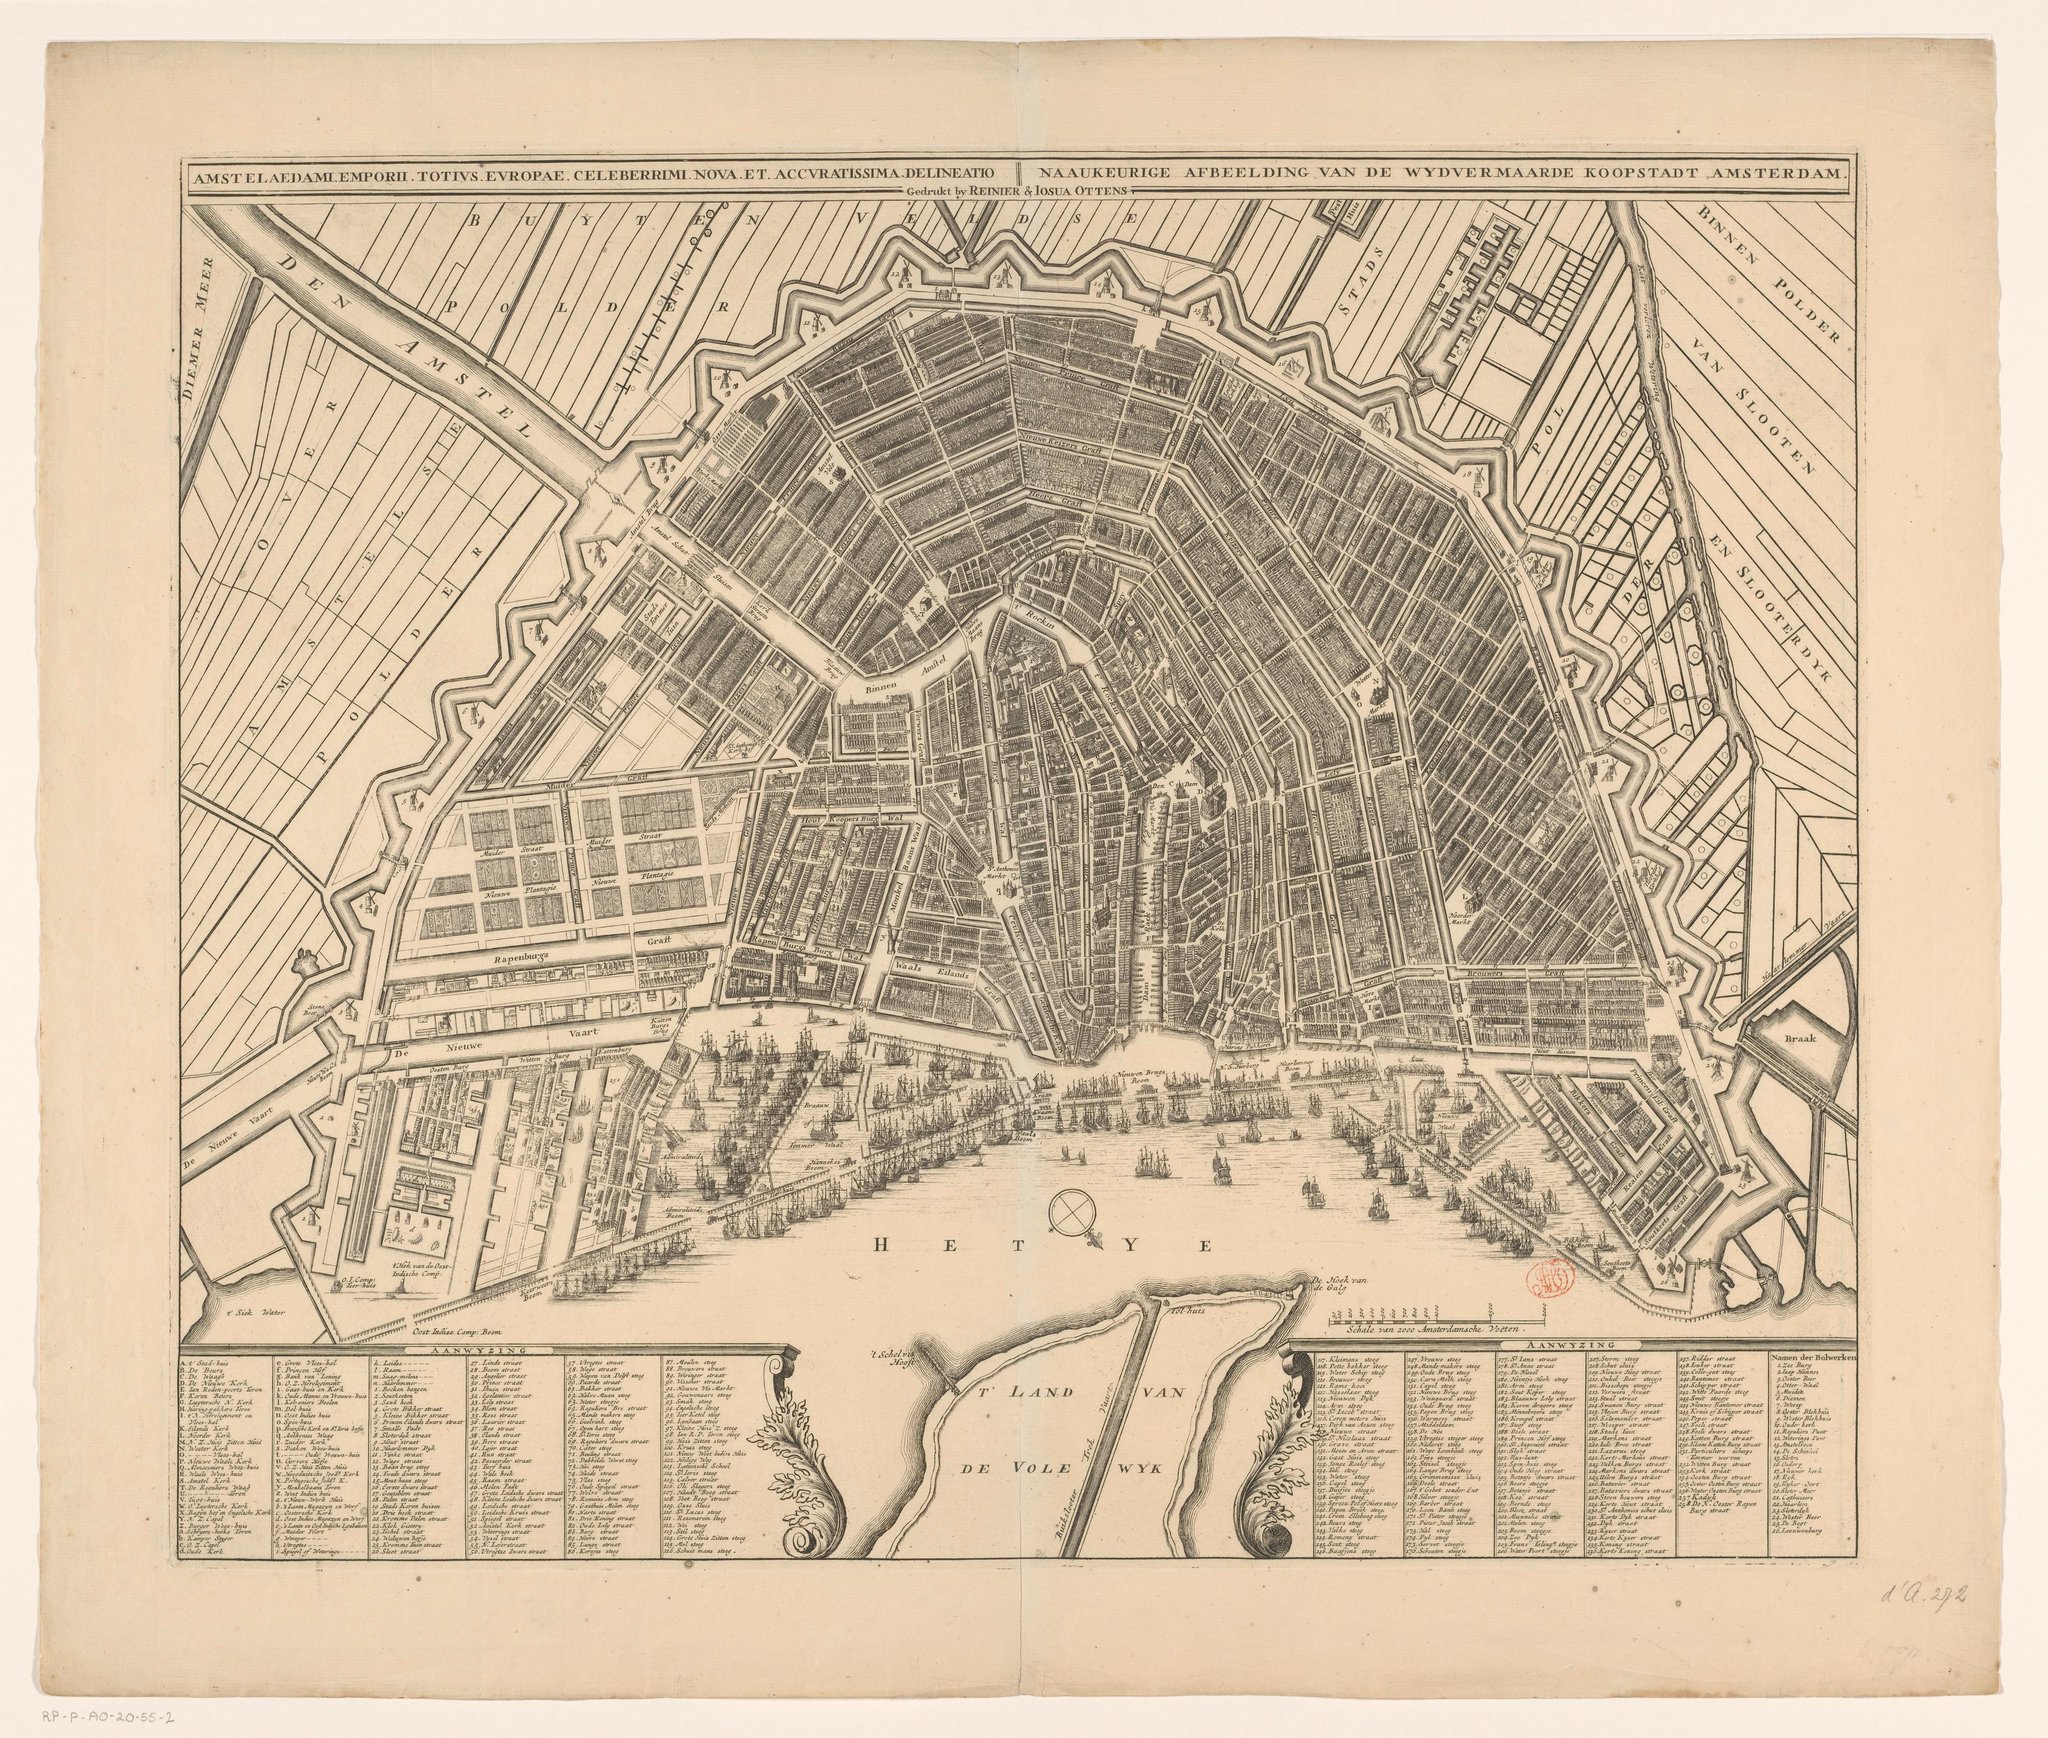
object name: area plan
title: Naaukeurige afbeelding van de wydvermaarde koopstadt Amsterdam / Amstelaedami. Emporii. Totius. Europae. Celeberrimi. Nova. Et. Accuratissima. Delineatio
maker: Anonymous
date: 1726-1750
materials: paper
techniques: engraving, etching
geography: amsterdam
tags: maps of cities, amsterdam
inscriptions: collector's mark: Lugt 195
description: Plattegrond in vogelvluchtperspectief. Langs de bovenkant de titel. Linksonder de legenda A-Z, a-z, a-n en 1-116. Rechtsonder de legenda 117-258 en de legenda van de bolwerken 1-26. Daarboven een schaalstok: Scale van 2000 Amsterdamsche Voeten. Oriëntatie: zuidzuidwest boven.